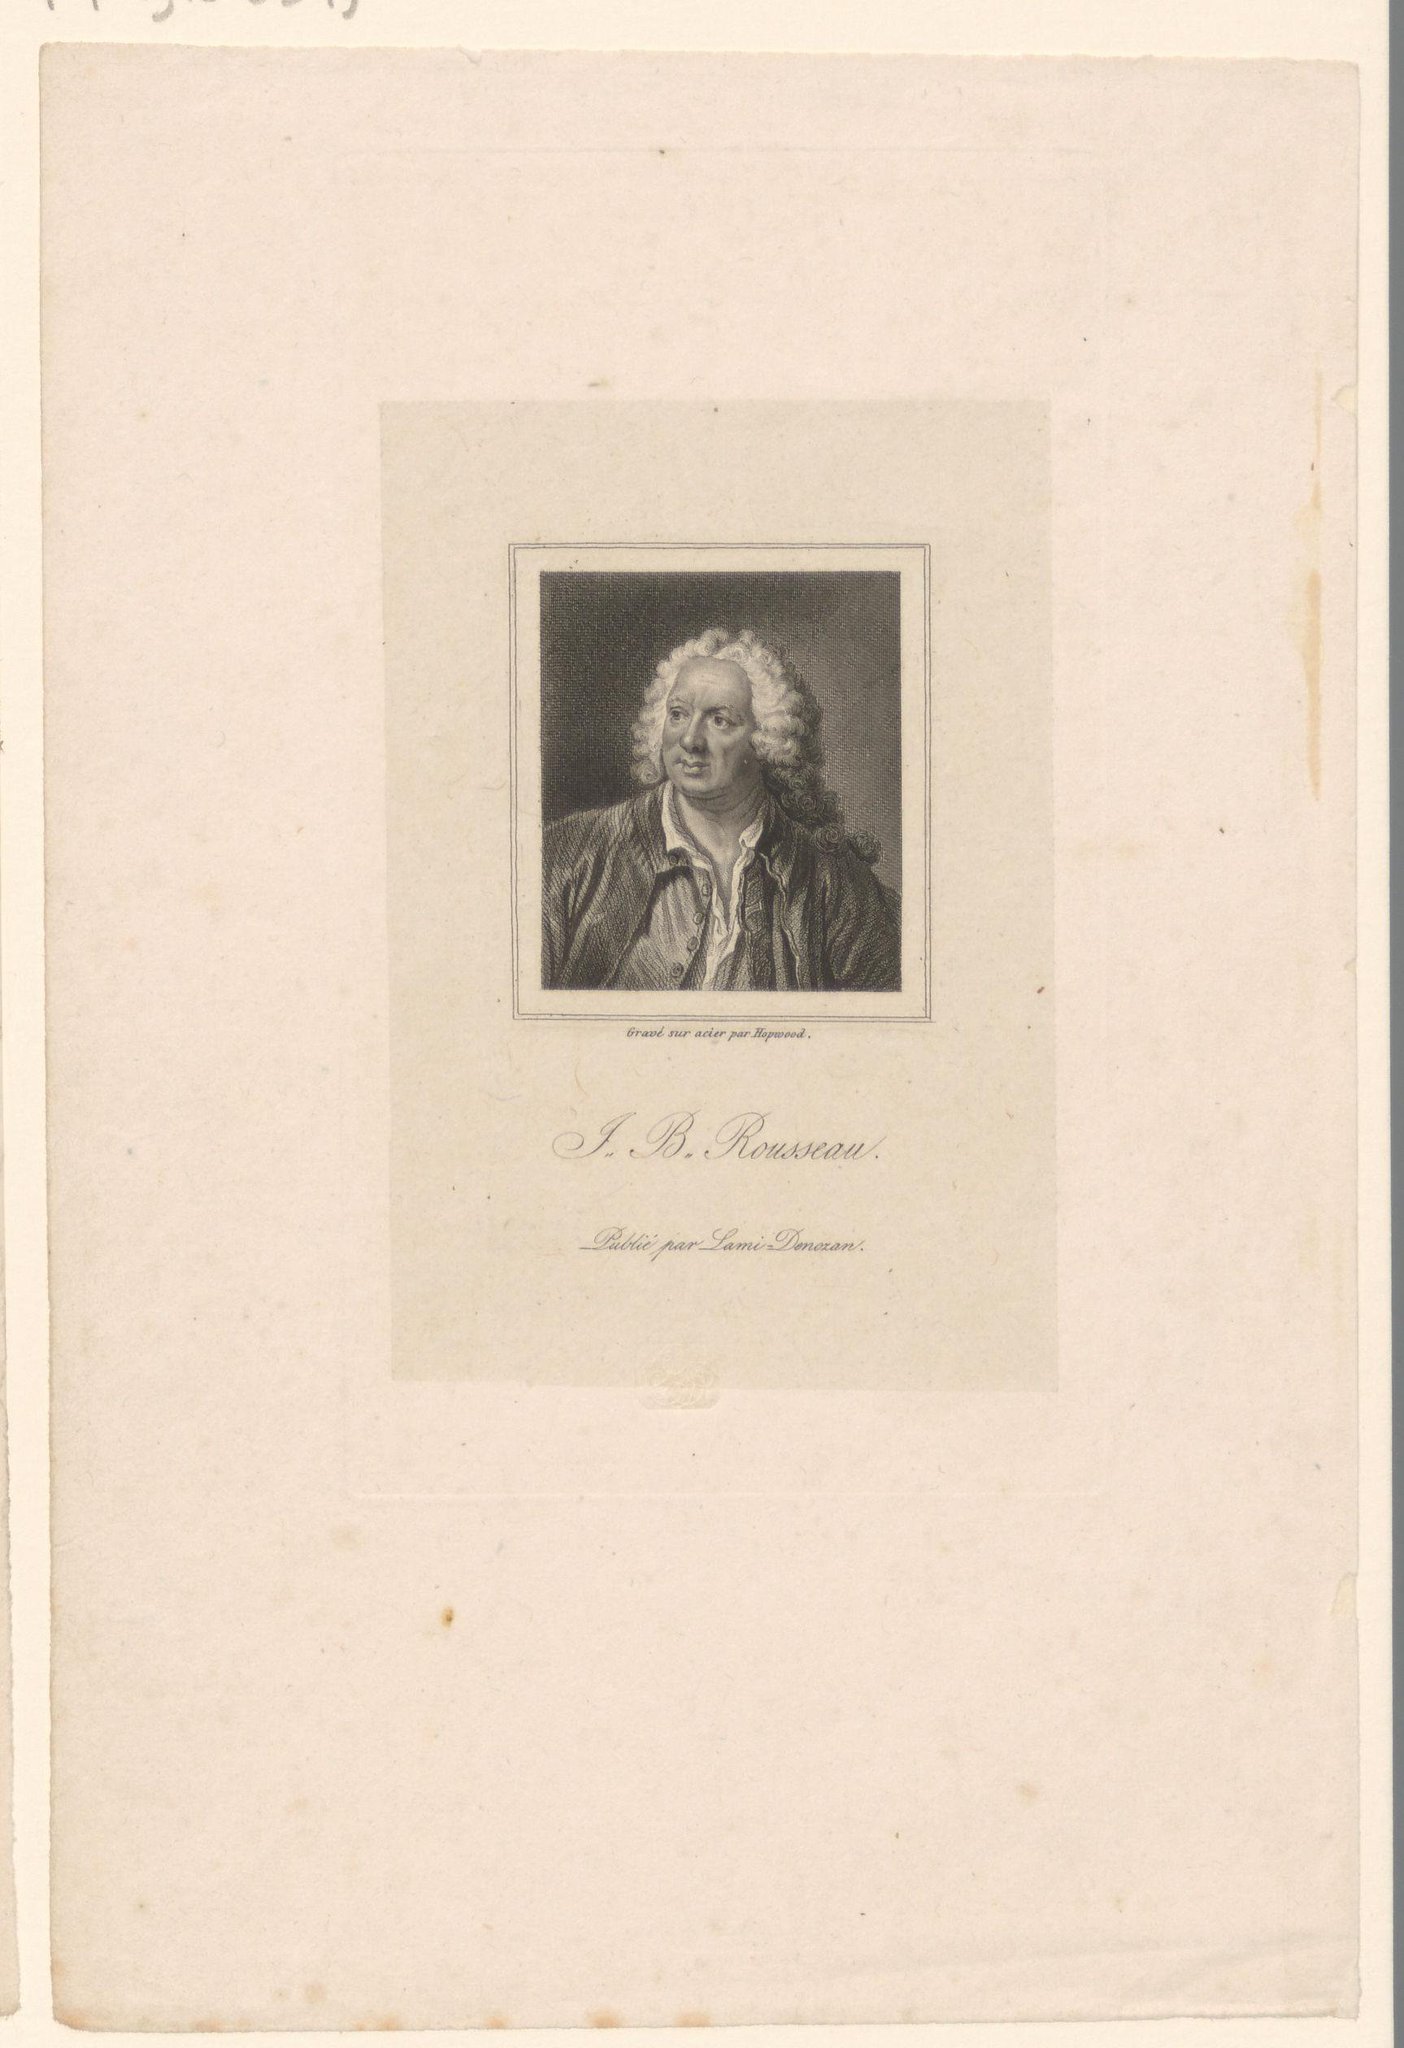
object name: print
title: J.B. Rousseau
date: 1828-1850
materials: paper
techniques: etching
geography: paris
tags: paris, brussels, jean baptiste rousseau (1669-1741), historical persons, portrait of a writer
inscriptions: check stamp: ‘A[?]’, collector's mark: Lugt 2228